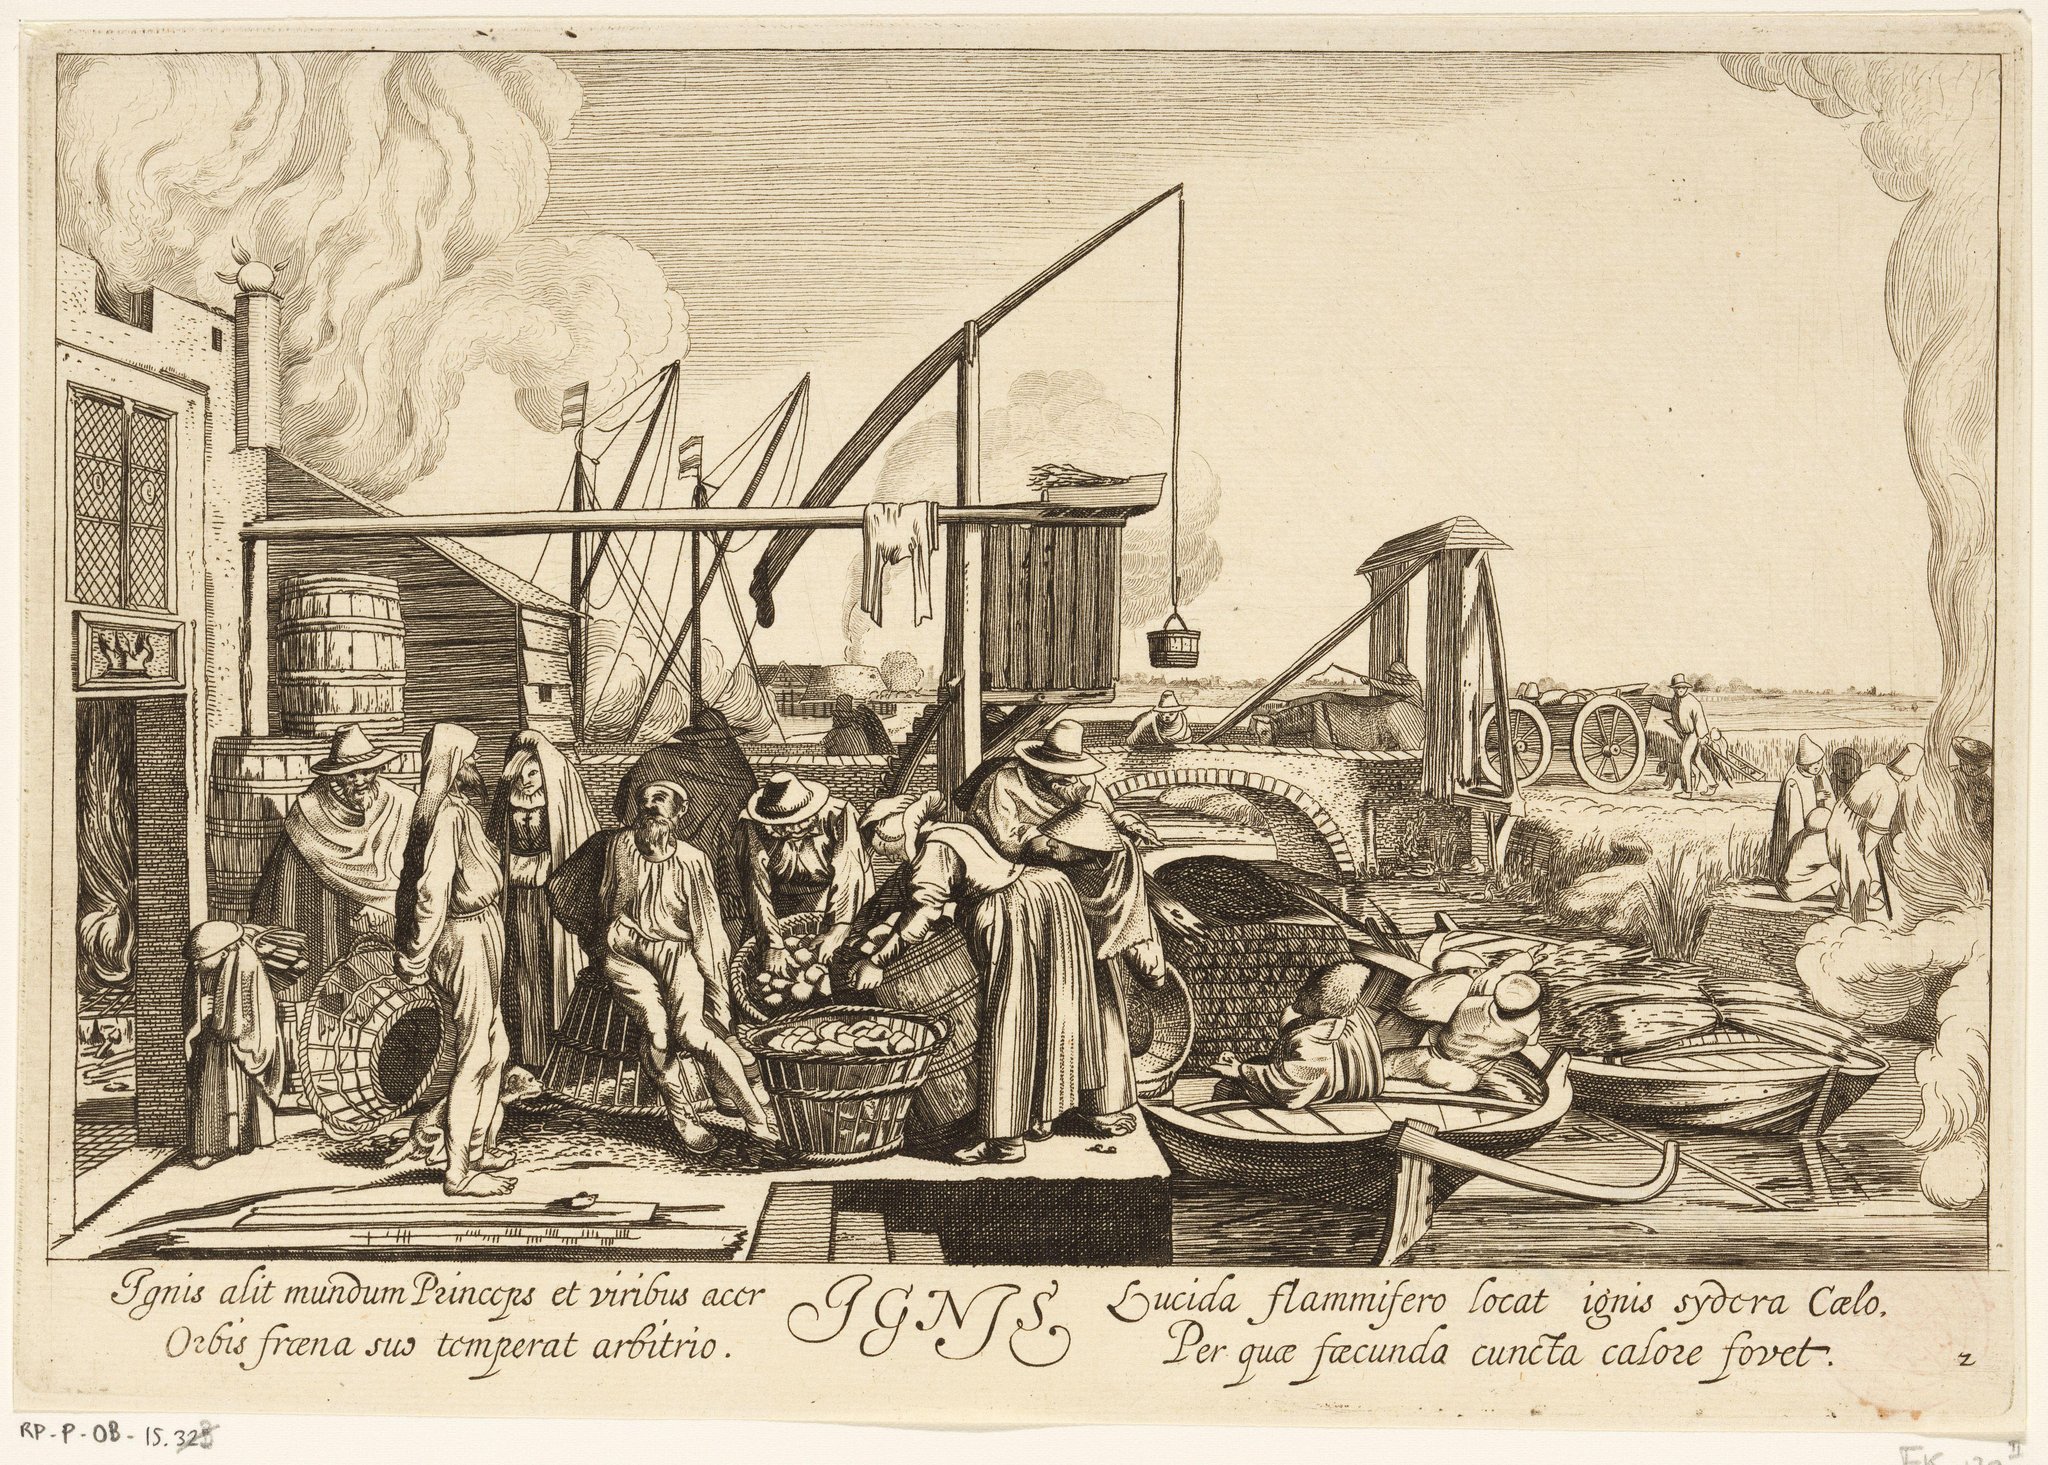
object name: print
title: De vier elementen B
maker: jan van de velde (ii)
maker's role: draughtsman, painter, print maker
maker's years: 1593-1641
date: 1622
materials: paper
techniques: engraving, etching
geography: northern netherlands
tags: smoke, smoke-stack, fire (one of the four elements), open fire (in general), smith, blacksmith, burning as process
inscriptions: collector's mark: Lugt 240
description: Landschap met figuren, voorstellende het element vuur. Links een smederij, op de achtergrond kalkovens en rechts figuren bezig met vuur op het land. Tweede prent uit een serie van vier met landschappen als verbeeldingen van de vier elementen.